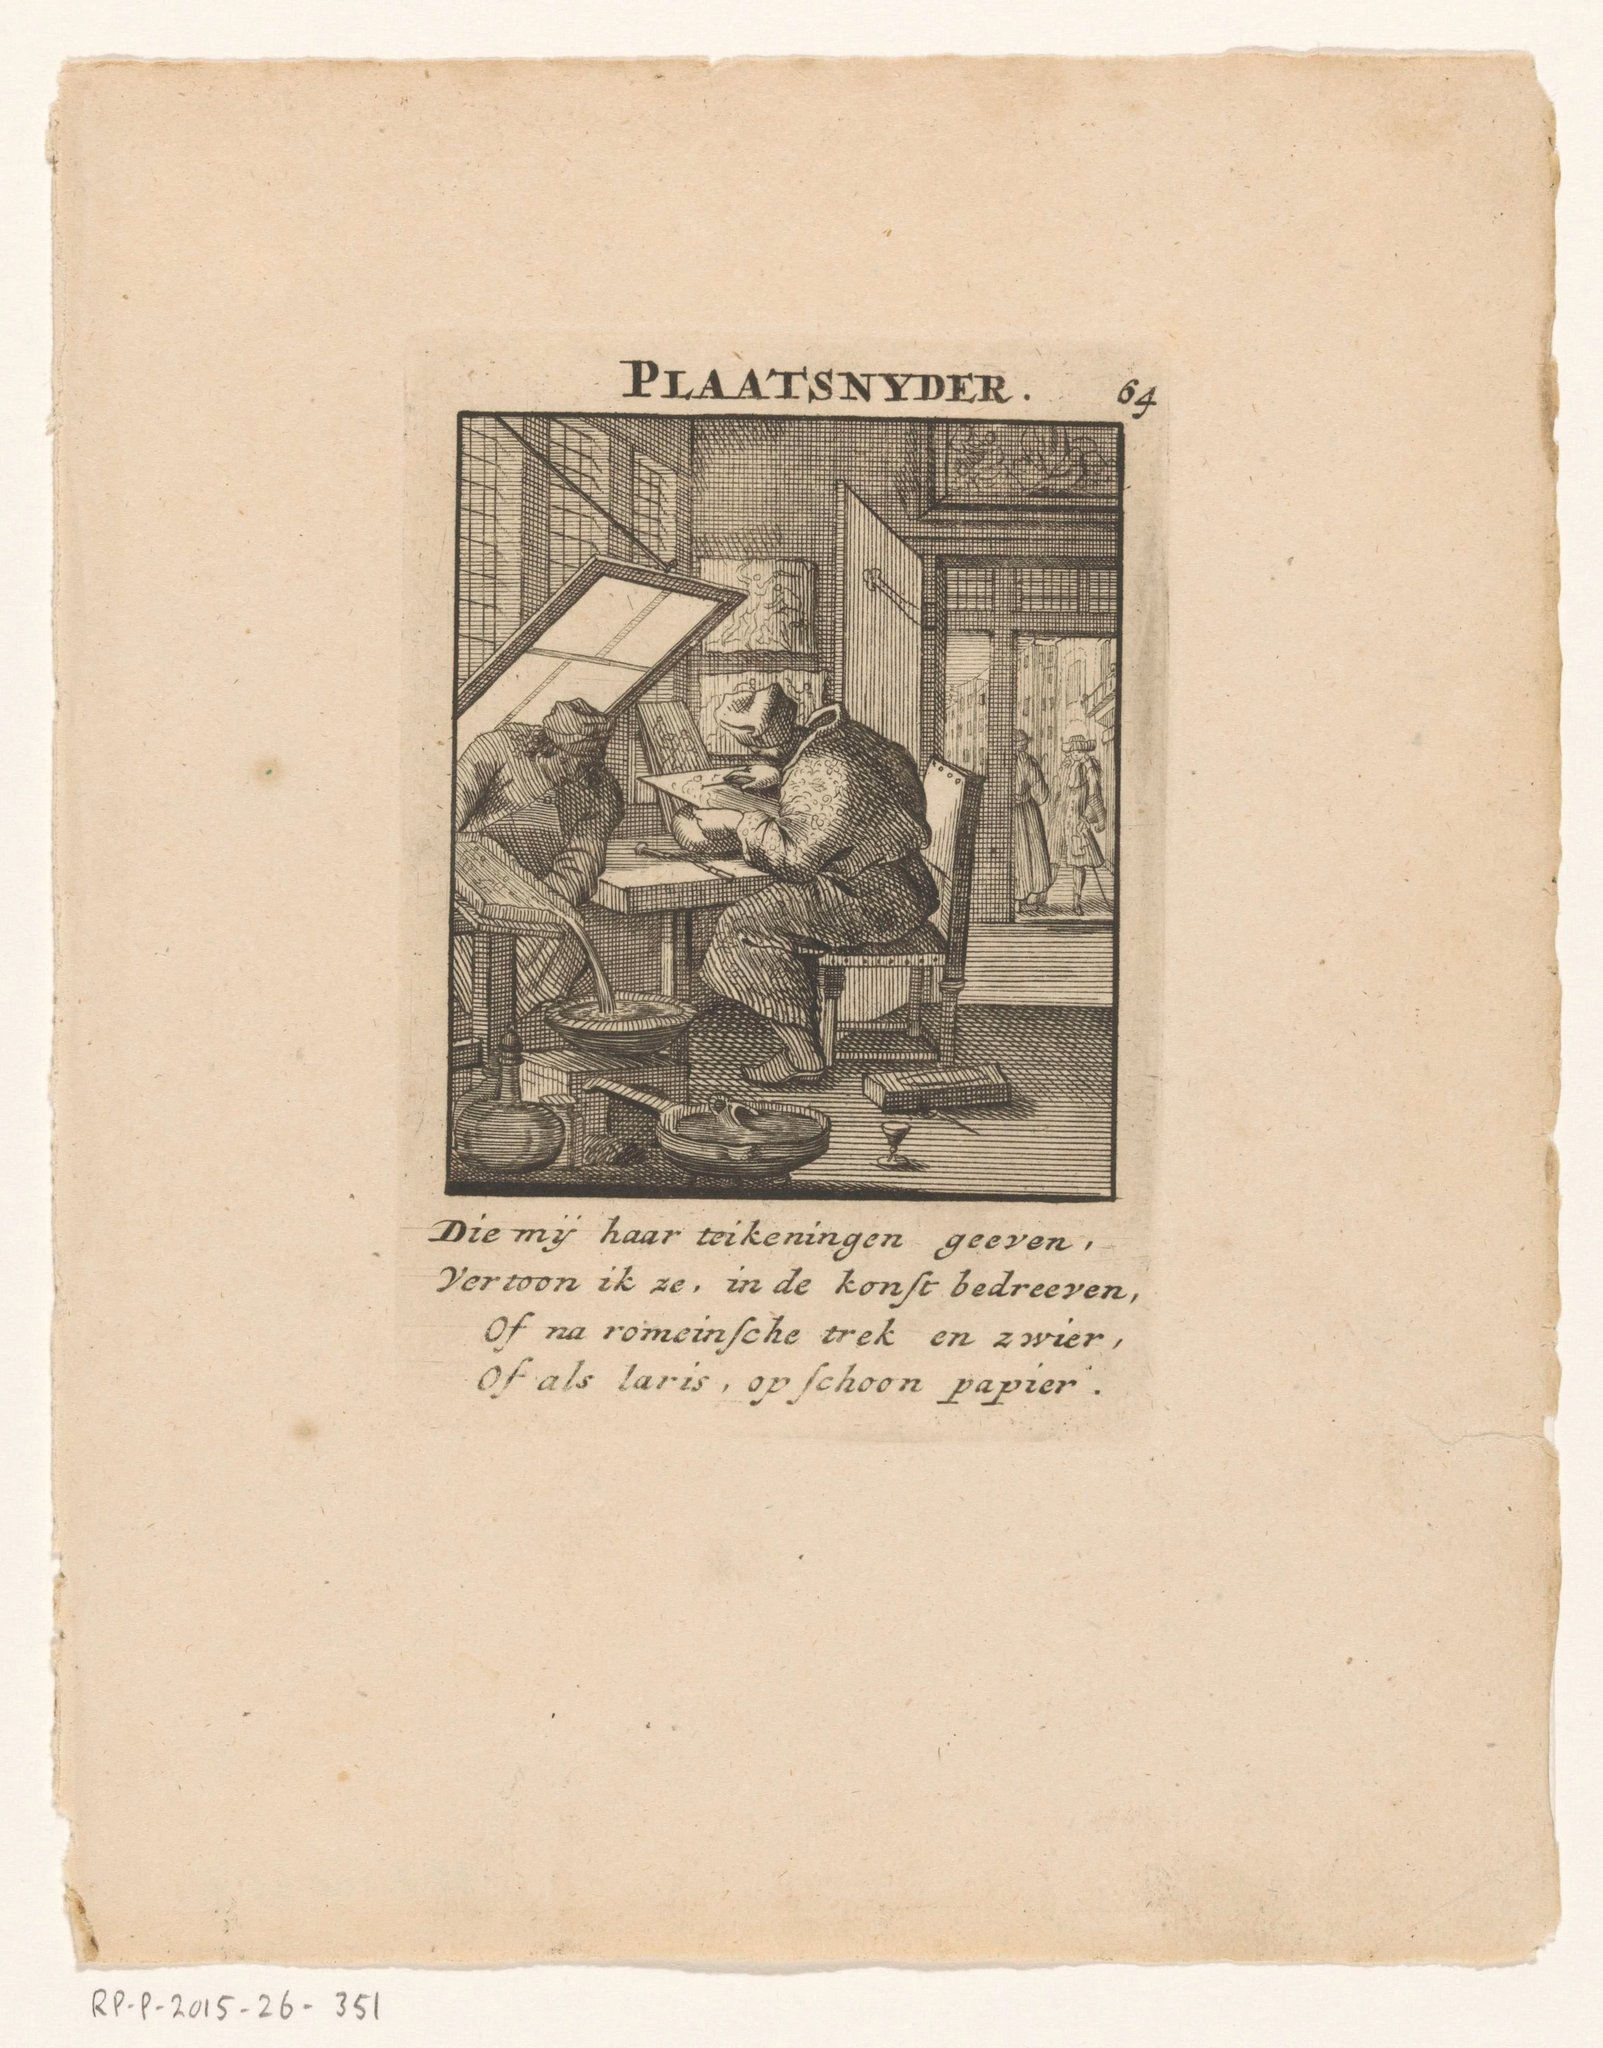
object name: print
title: Plaatsnijder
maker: Anonymous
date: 1700-1800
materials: paper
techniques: etching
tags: handicrafts, craftsman at work, engraver, etcher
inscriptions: collector's mark: Lugt 4779, watermark: ‘Pro Patria, Nederlandse maagd met de Hollandse leeuw in de tuin’, collector's mark: Lugt 2228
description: Prent afkomstig uit een 18e-eeuwse roofdruk van de originele serie van 100 beroepsprenten door Jan en Caspar Luyken, getiteld: Het menselyk bedryf. S.l.s.n., 1694 (eerste druk).